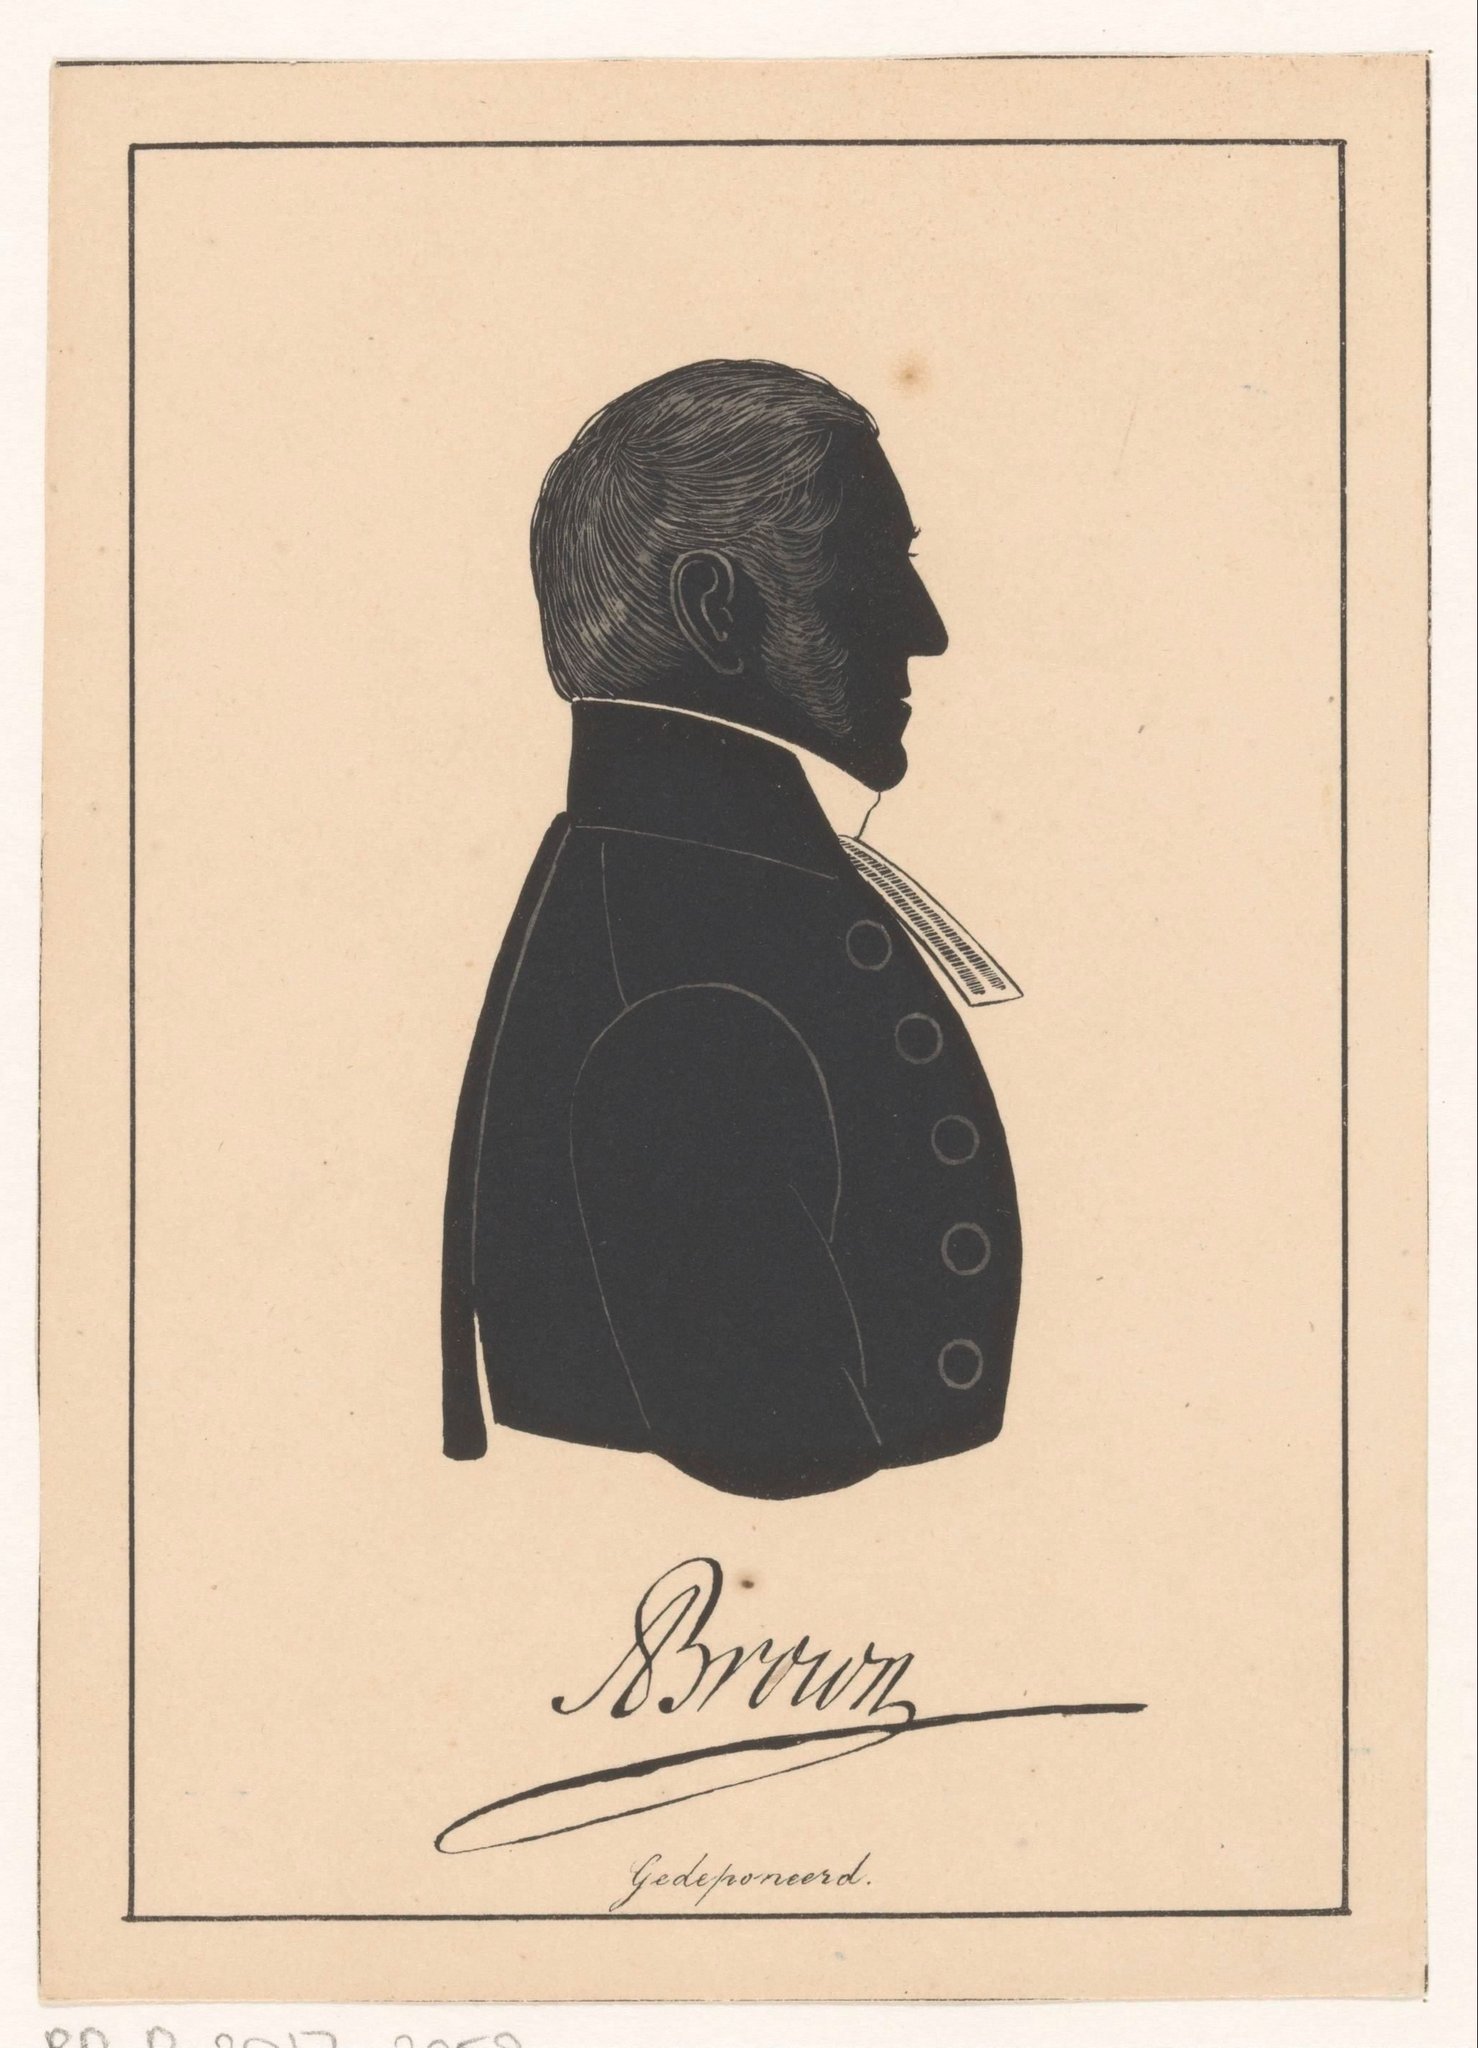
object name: print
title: Silhouetportret van Alef Brown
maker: pieter barbiers (iv)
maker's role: painter, print maker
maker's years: 1798-1848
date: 1809-1848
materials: paper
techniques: hand coloring, lithograph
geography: netherlands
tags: arnhem, leiden, historical persons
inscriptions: : ‘Gedeponeerd.’, collector's mark: Lugt 2228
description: Onder het portret de signatuur van de geportretteerde.